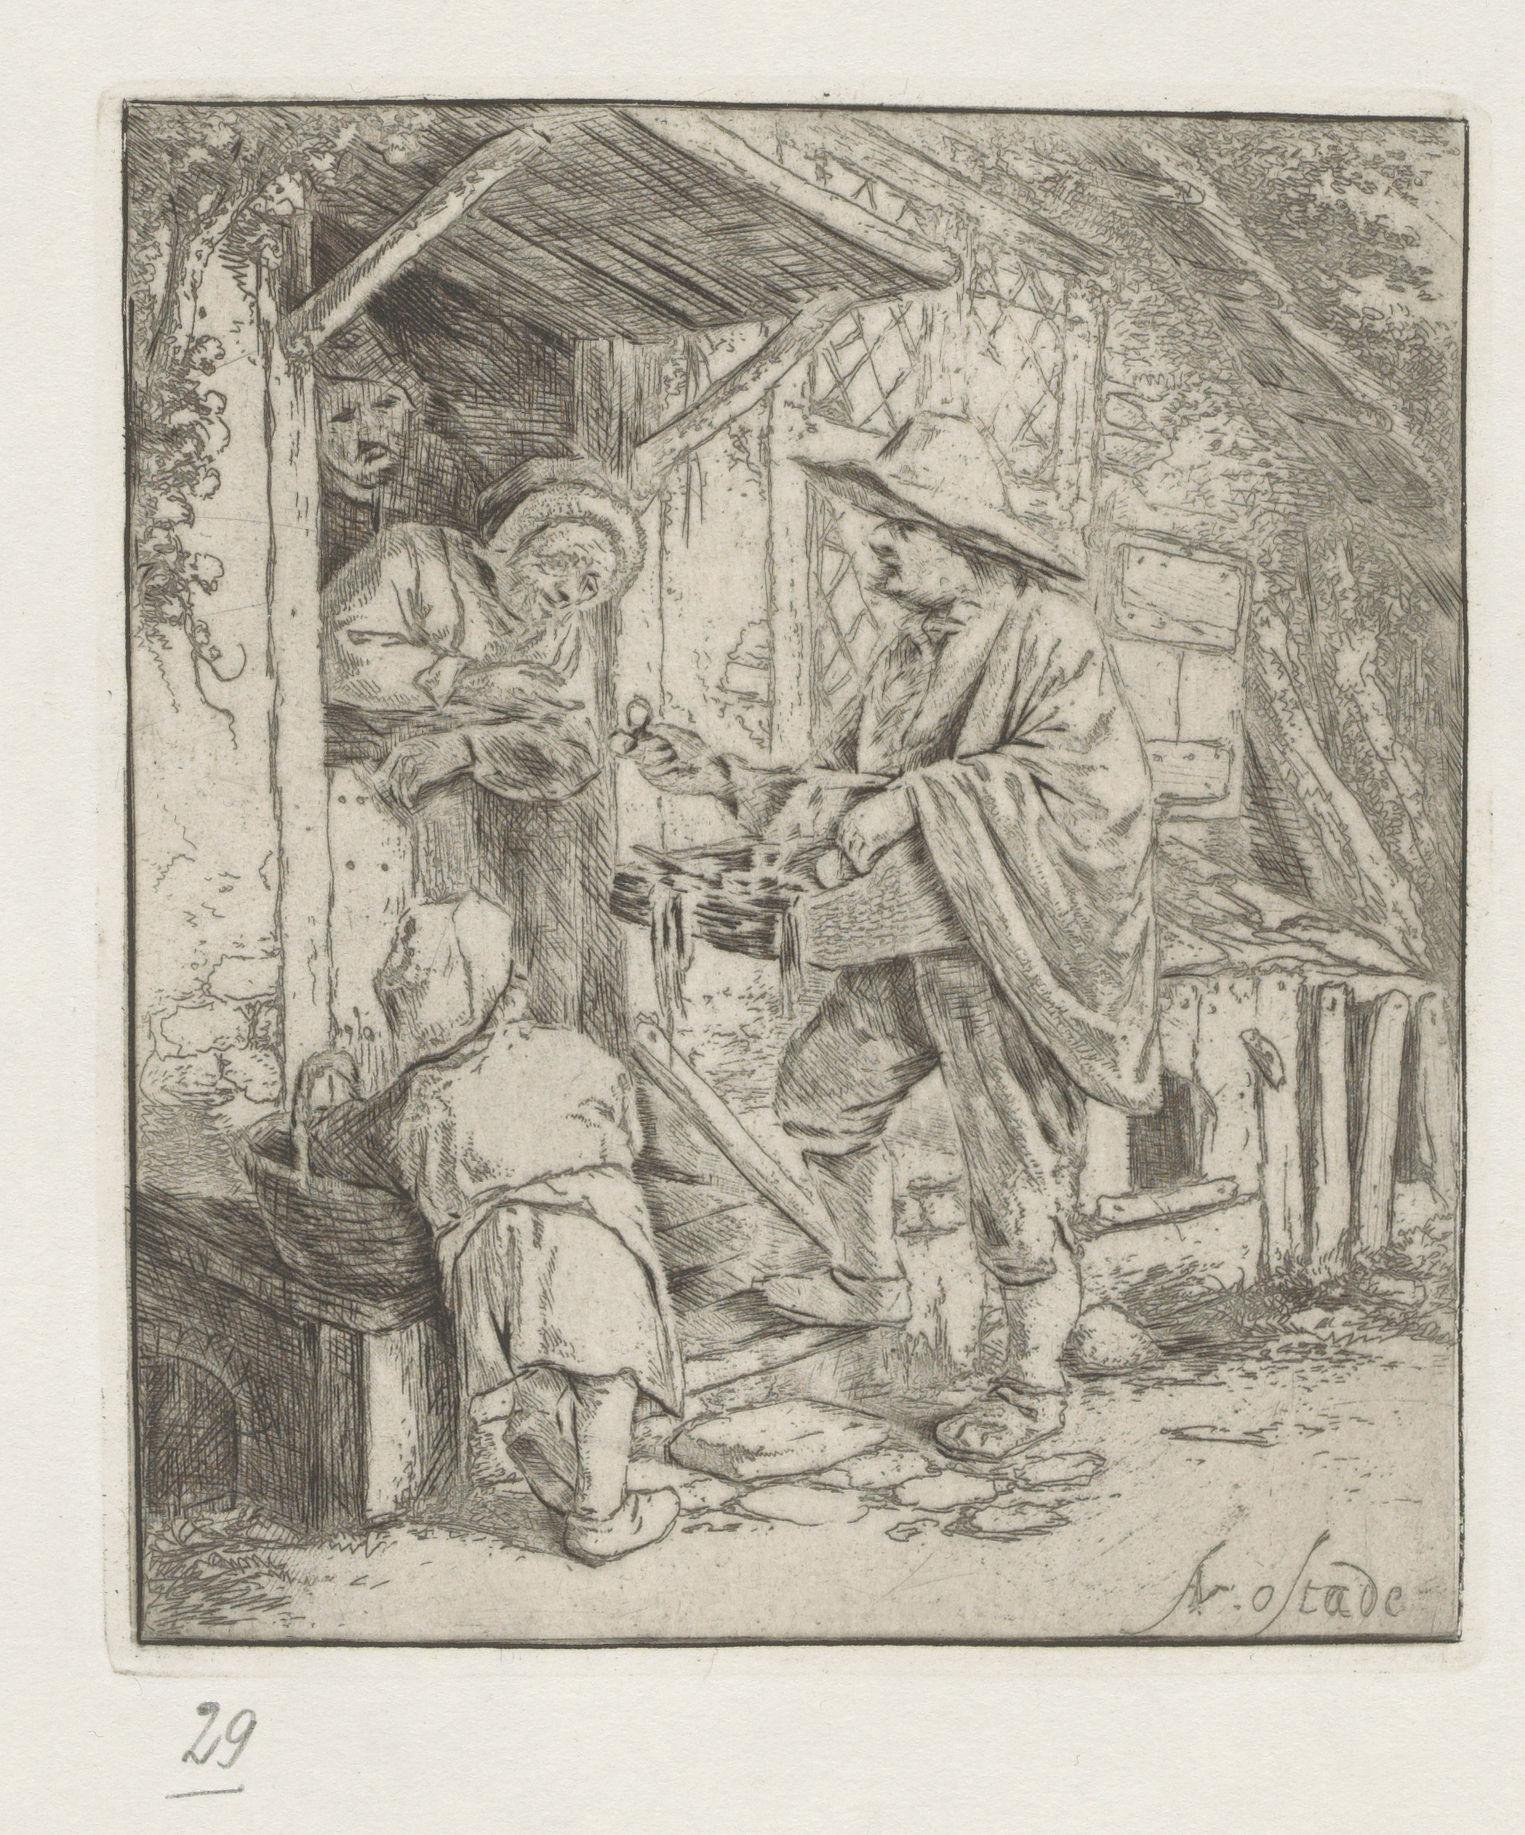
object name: print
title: Brillenverkoper en een oude vrouw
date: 1647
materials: paper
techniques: etching, galvanization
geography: haarlem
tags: eyeglasses, spectacles, old woman, wandering or travelling merchant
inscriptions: collector's mark: ‘RIJKS / MUSM’, collector's mark: ‘B’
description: Een brillenverkoper met een mand vol brillen staat voor het huis van een oude vrouw. Zij leunt op de onderdeur terwijl ze een bril krijgt aangereikt. Een kind met een mand kijkt toe. De prent maakt deel uit van een portefeuille en is met een andere prent op één albumblad gedrukt.